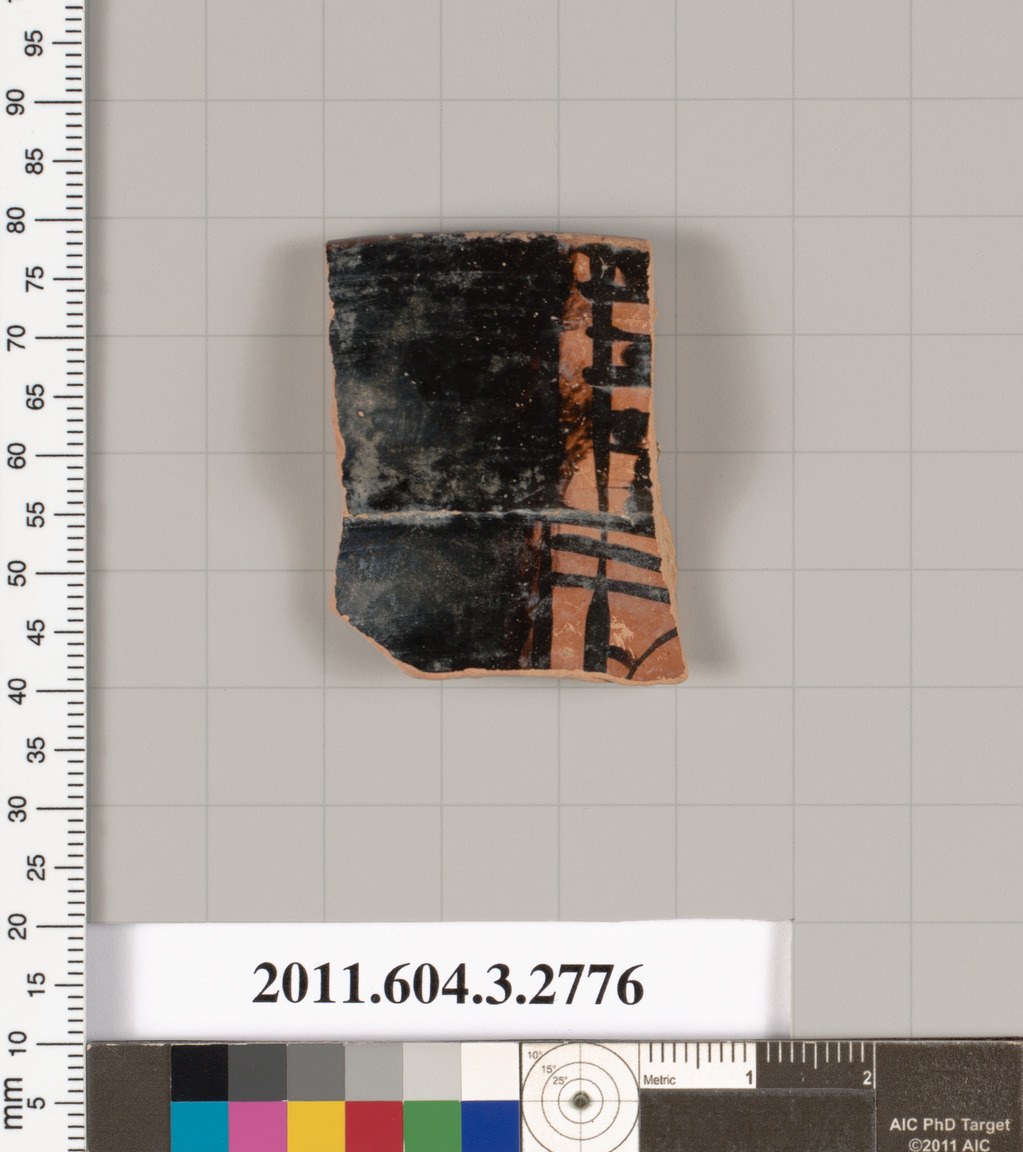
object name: olpe fragment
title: Terracotta fragment of an olpe (jug)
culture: greek, attic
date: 530-520 BCE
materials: terracotta